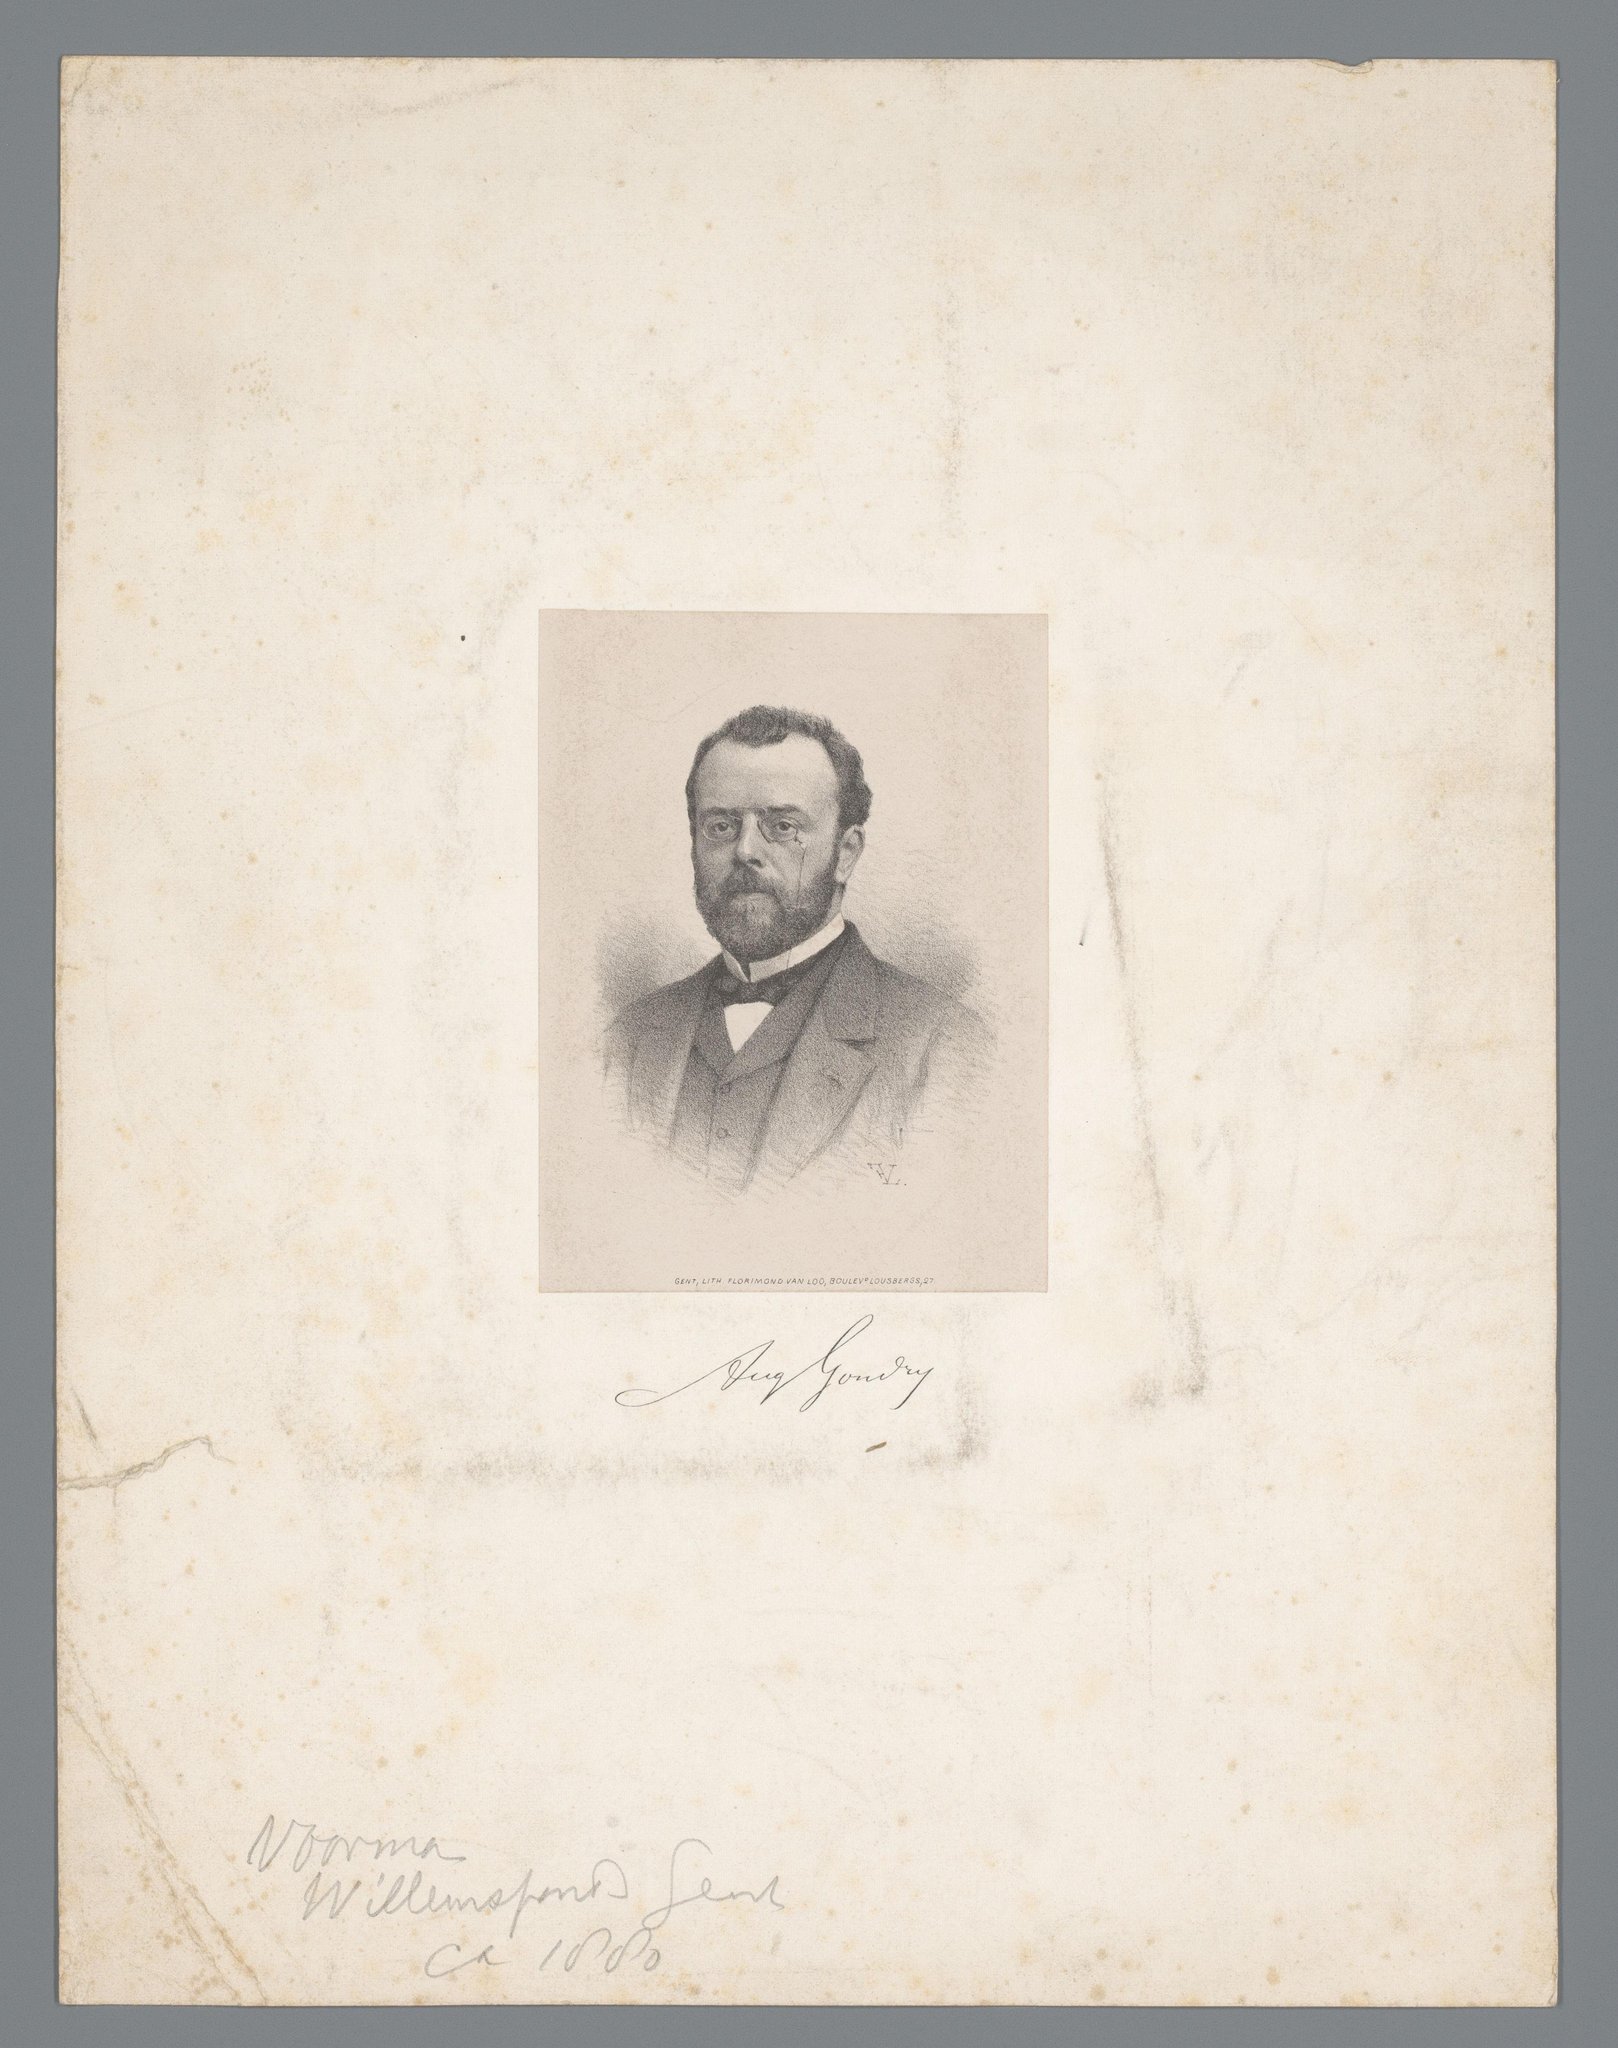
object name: print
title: Aug. Gondry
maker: florimond van loo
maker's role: print maker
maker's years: 1823-1901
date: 1865-1901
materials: paper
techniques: lithograph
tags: ghent, eyeglasses, spectacles, adult man, historical persons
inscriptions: collector's mark: Lugt 2233